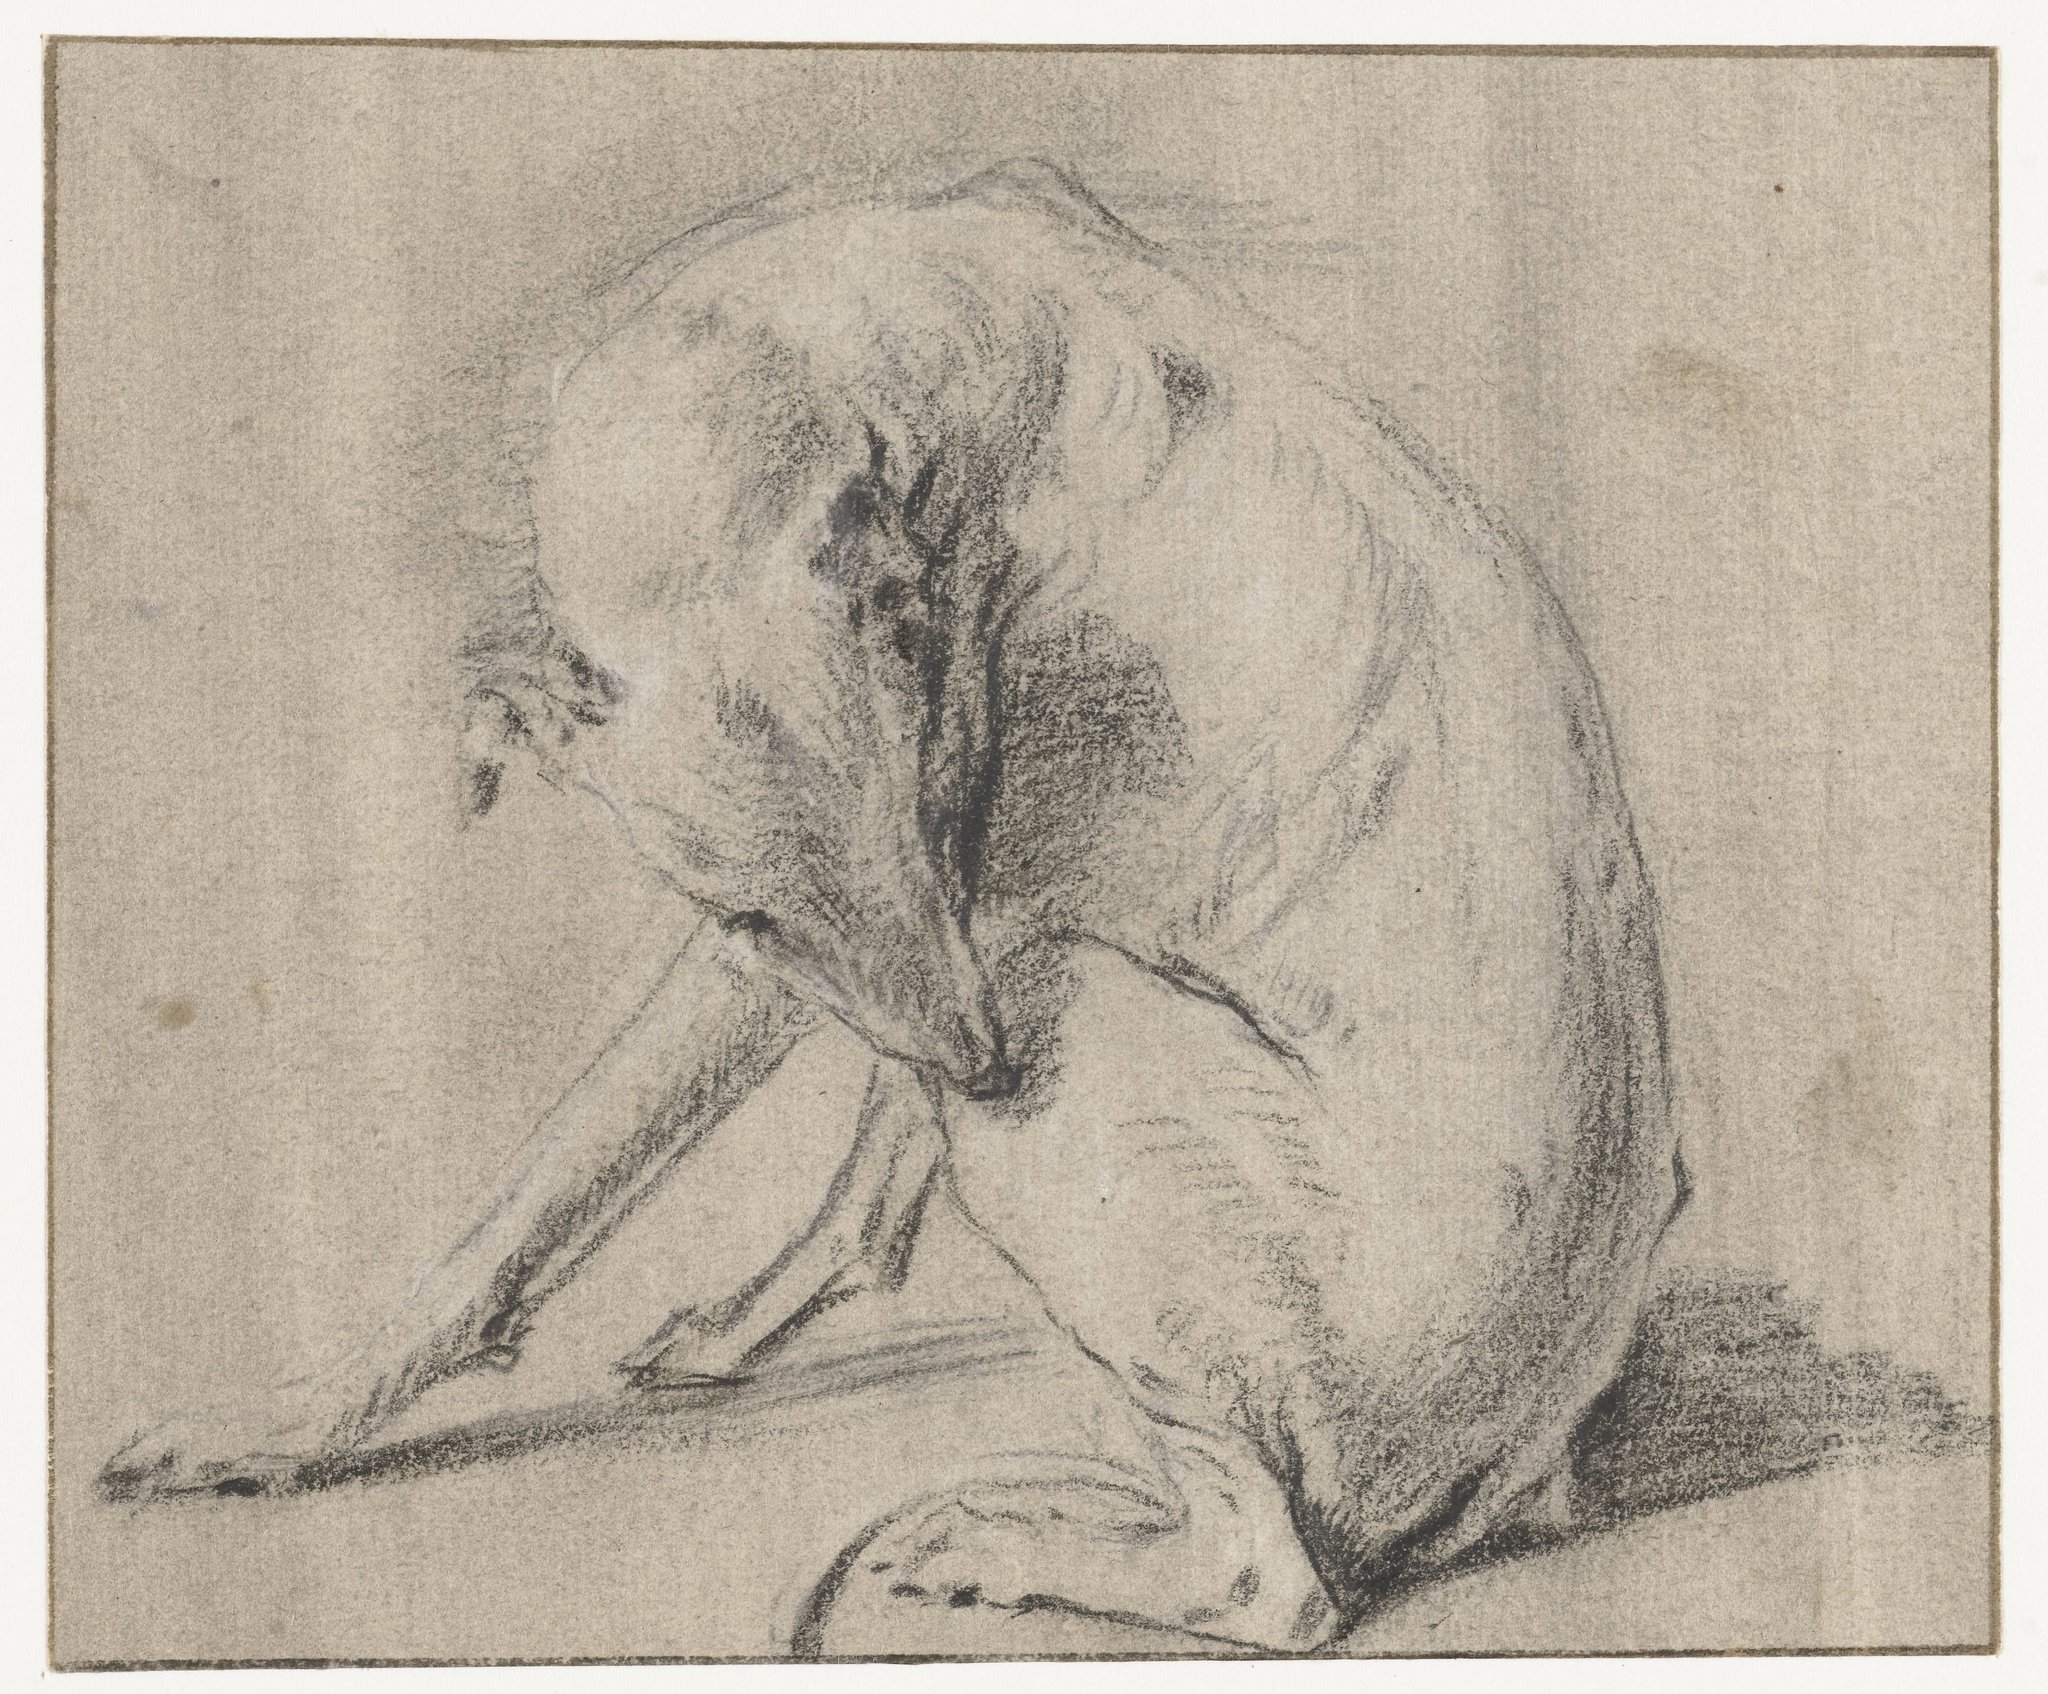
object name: drawing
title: Een zittende hond die in zijn achterpoot bijt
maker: frans snijders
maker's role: draughtsman, painter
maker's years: 1579-1657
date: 1589-1657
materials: chalk, paper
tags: dog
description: Een zittende hond, van opzij gezien, bijtend in zijn linkerachterpoot.